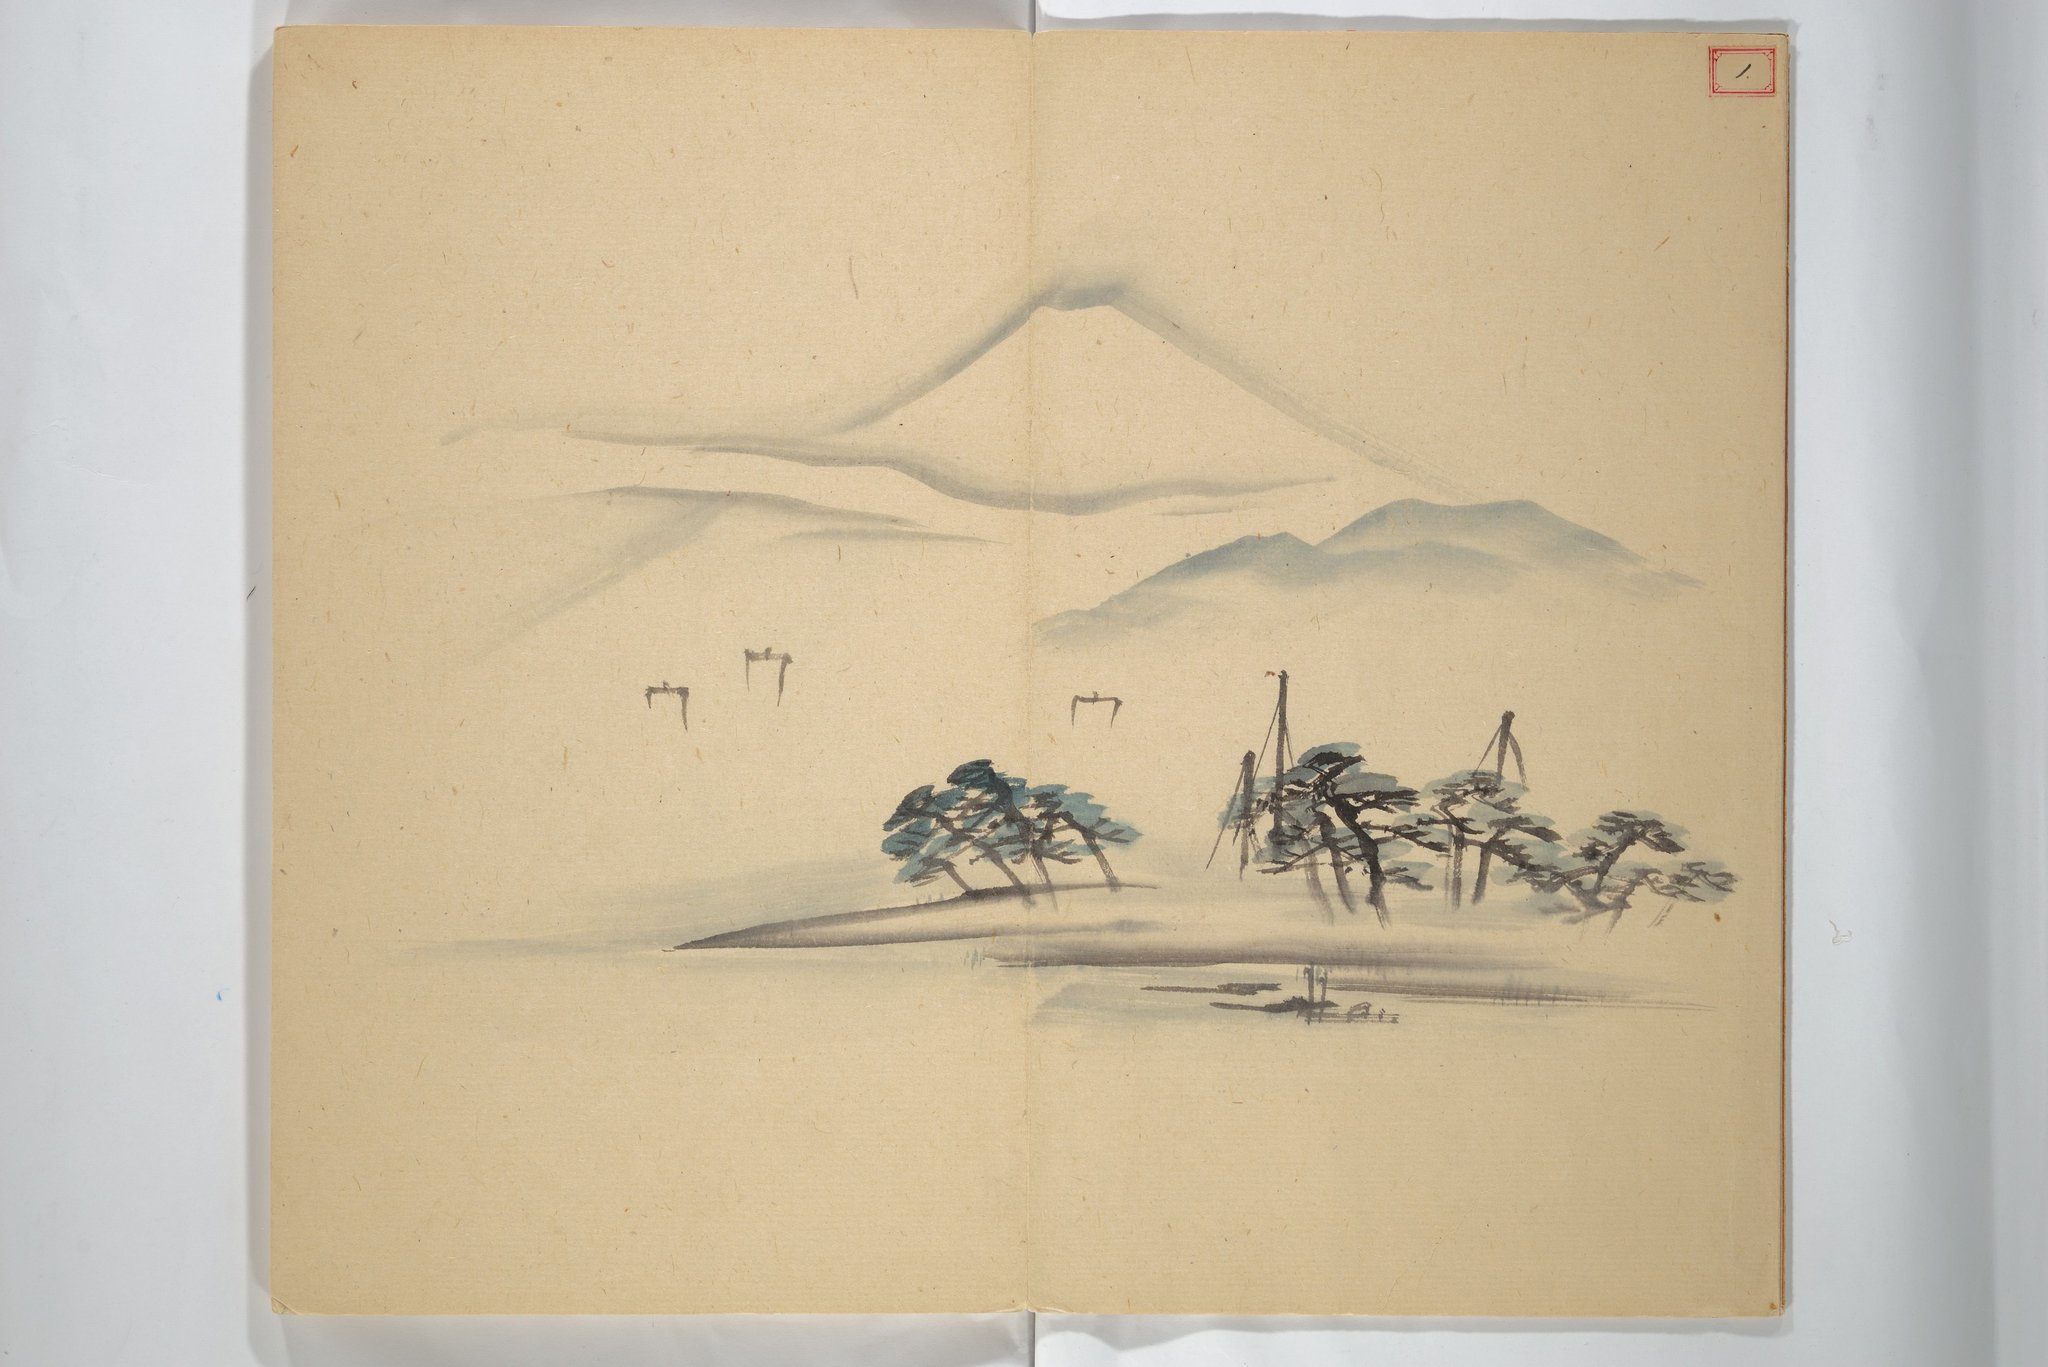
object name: illustrated book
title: Album [of works] by the master Koiso Zensetsusō (complete) (Koiso Zensentsusō sensei gajō-kan) 小磯前雪窓先生画帖完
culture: japanese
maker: koiso zensetsusō 小磯前雪窓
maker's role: artist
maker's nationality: japanese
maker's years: 1832-1902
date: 1801-1900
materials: ink, paper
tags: mountains,landscapes,trees